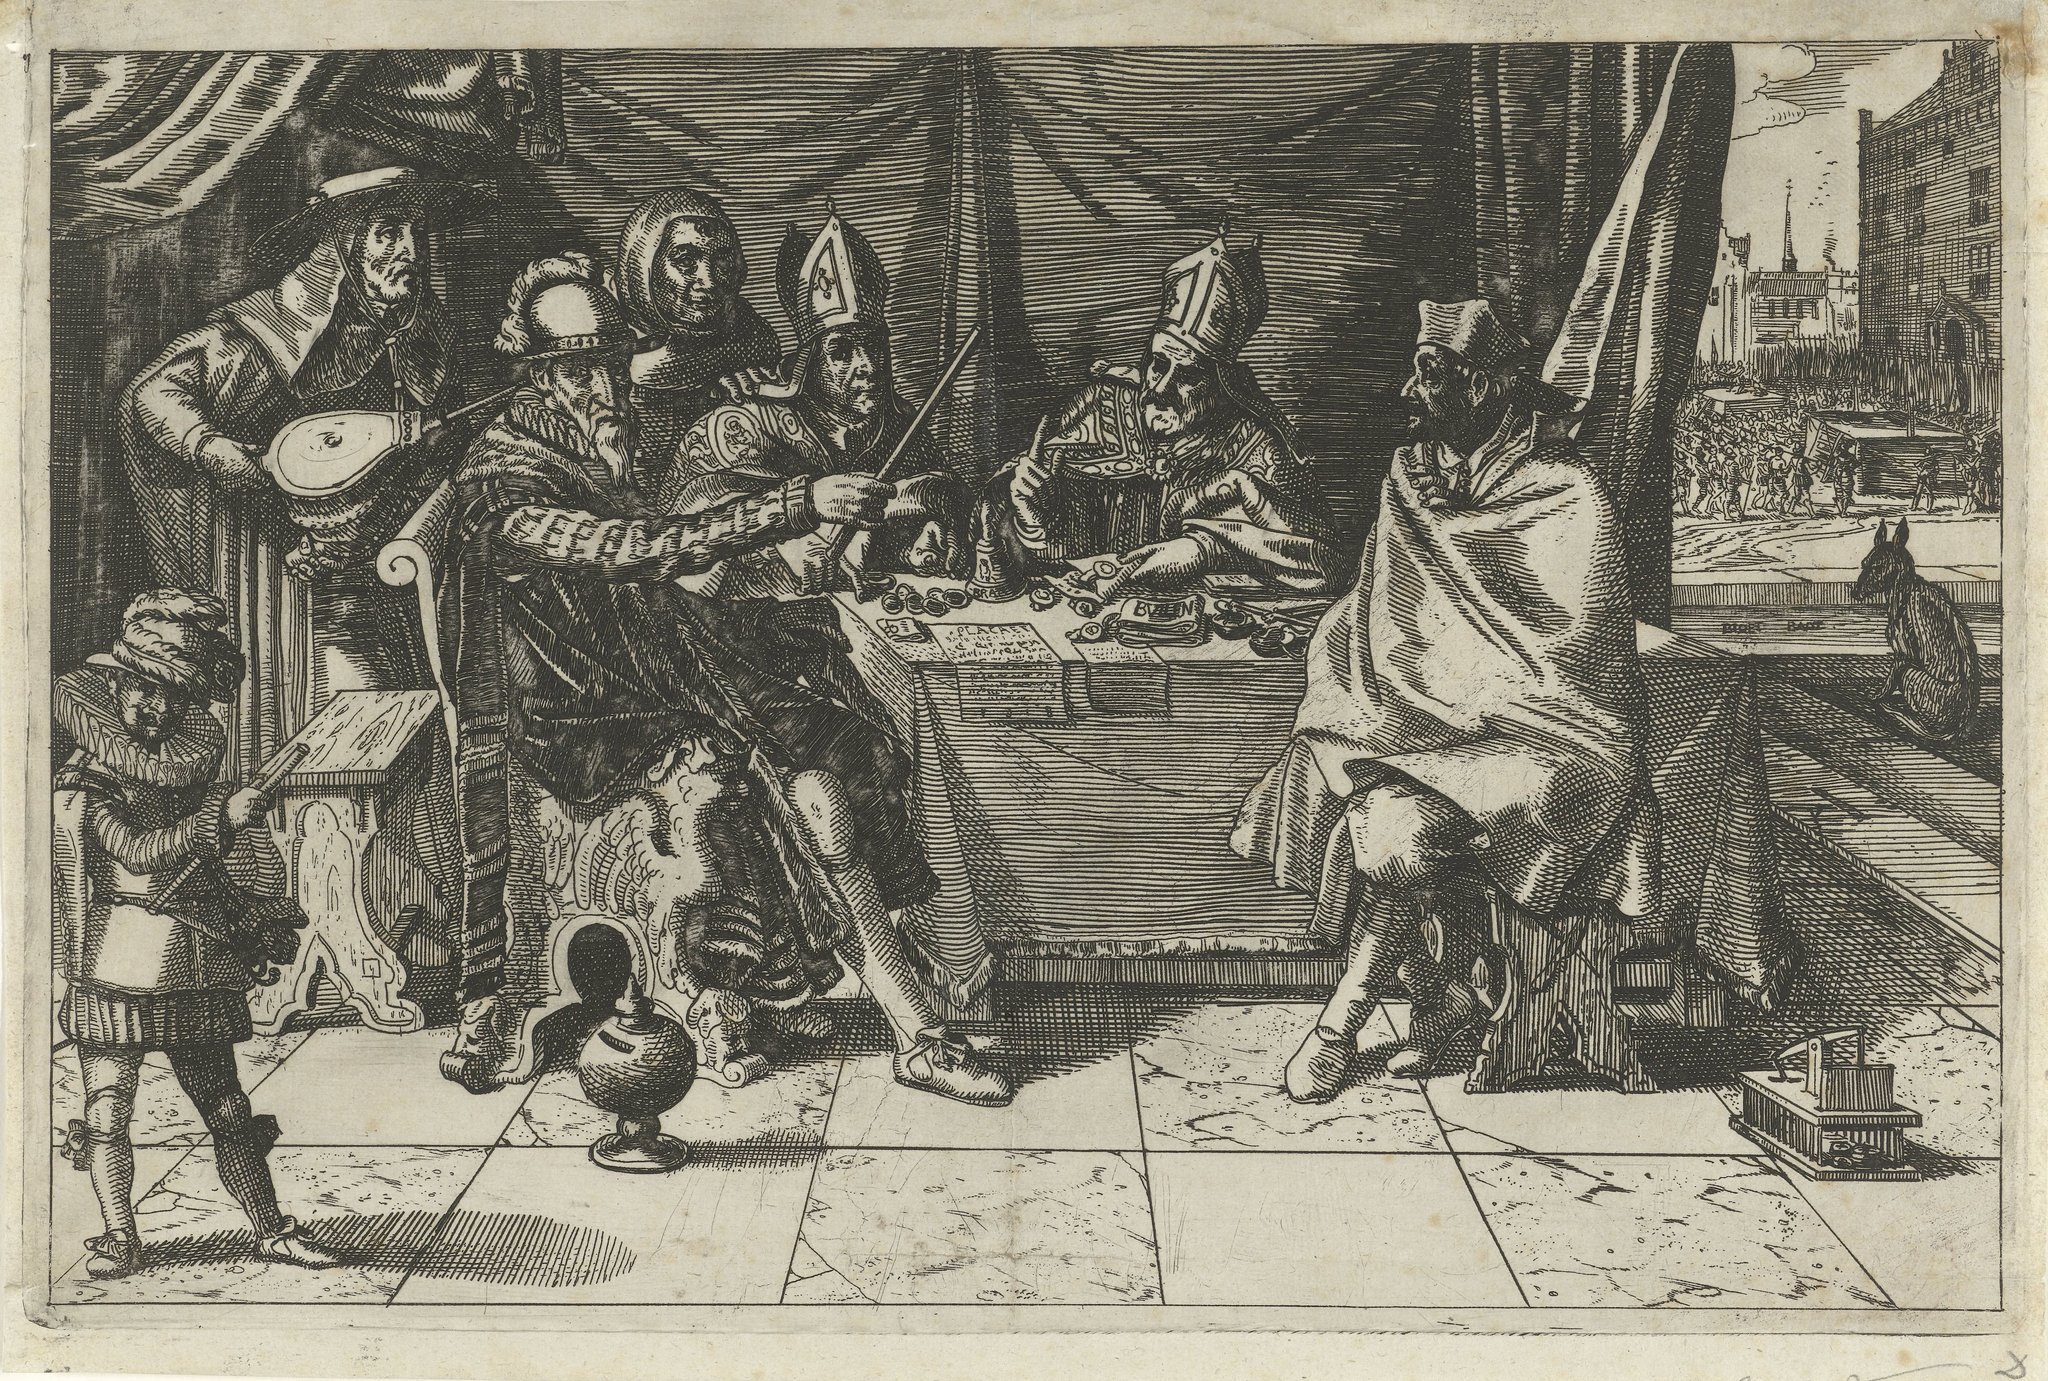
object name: print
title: Basisgedeelte van de spotprent op Oldenbarnevelt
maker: pieter feddes van harlingen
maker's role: painter, print maker, publisher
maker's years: 1586-1623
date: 1619-1623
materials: paper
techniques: etching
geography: friesland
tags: johan van oldenbarnevelt, fernando álvarez de toledo (3rd duke of alba)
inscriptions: collector's mark: Lugt 240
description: Bovenste deel behorende tot de spotprent op Oldenbarnevelt. Een ruimte met zeven personen en een hond. De hertog van Alva zit met twee bischoppen en een Jezuït aan tafel. Achter hem staat Granvelle. Op de achtergrond een gezicht op een menigte rondom een schavot.